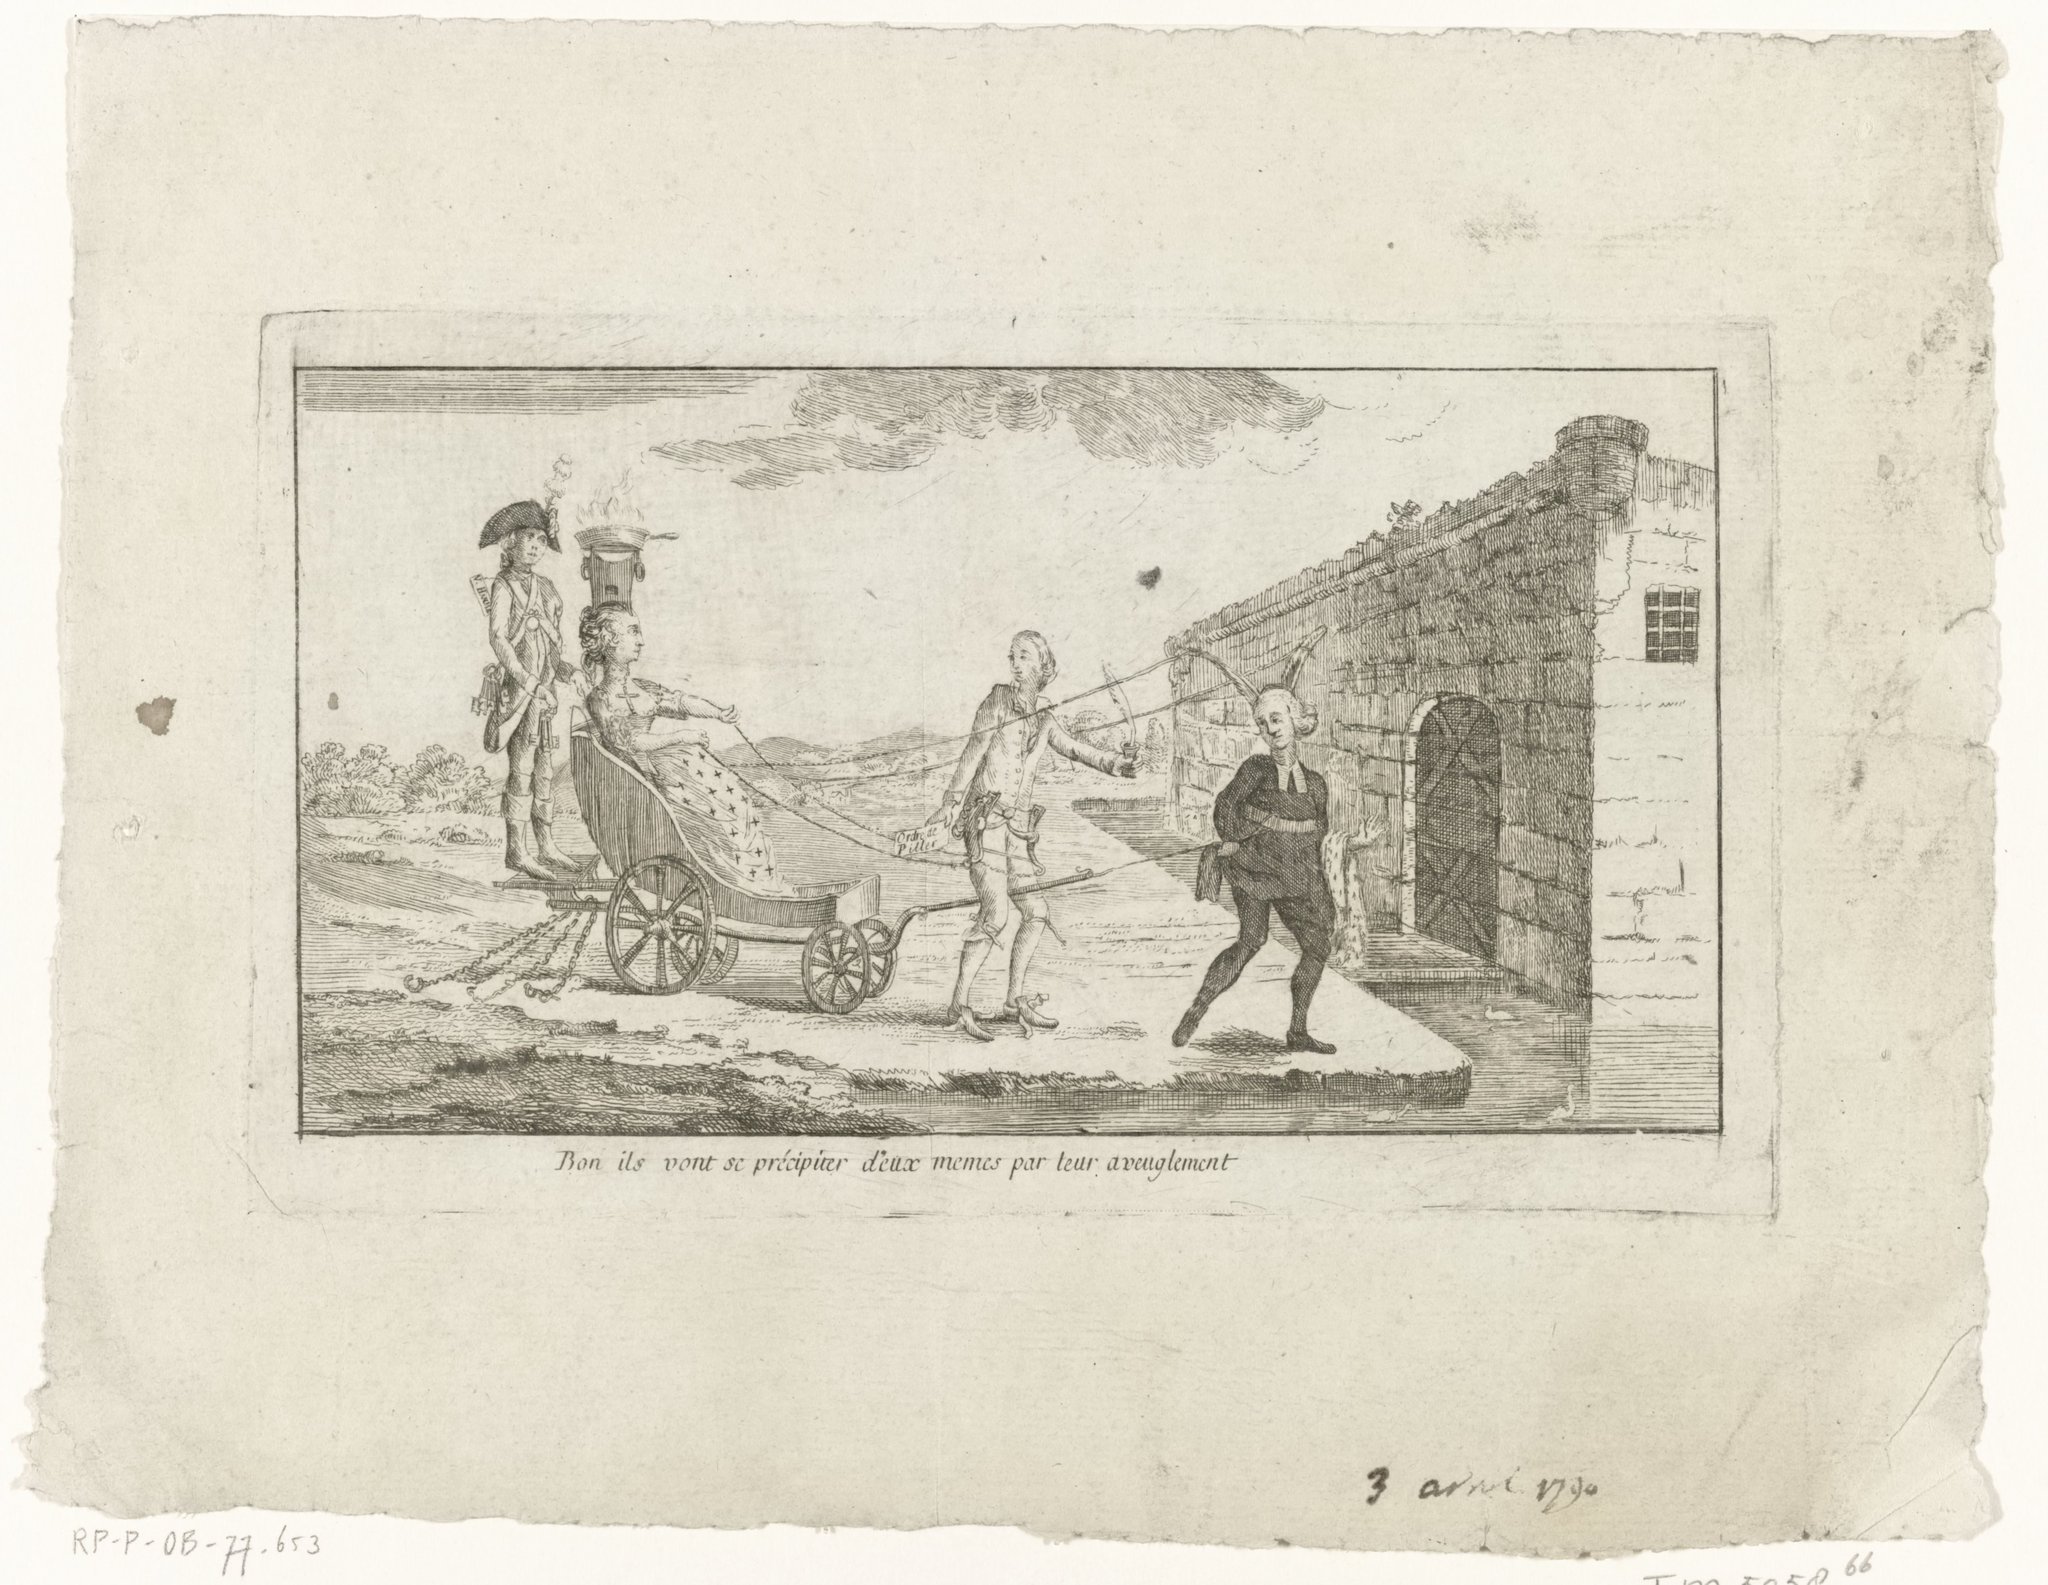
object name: cartoon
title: Bon ils vont se précipiter d'eux memes par leur aveuglement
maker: Anonymous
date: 1787-1790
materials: paper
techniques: engraving, etching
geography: southern netherlands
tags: brussels, politician, antwerp, priest, human being(s) drawing or pushing a vehicle not usually propelled by manpower, brabant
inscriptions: collector's mark: Lugt 2228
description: Spotprent op Hendrik van der Noot en Petrus van Eupen die zich voor de kar laten spannen van (de grote hoer) Madame Pinau, op de bok rijdt Van Hamme als palfrenier. Hierbij de datum 3 april 1790 met de hand geschreven. Onderdeel van een grote groep van prenten betrekking hebbend op de gebeurtenissen van de Brabantse Omwenteling en de periode 1787-1790.